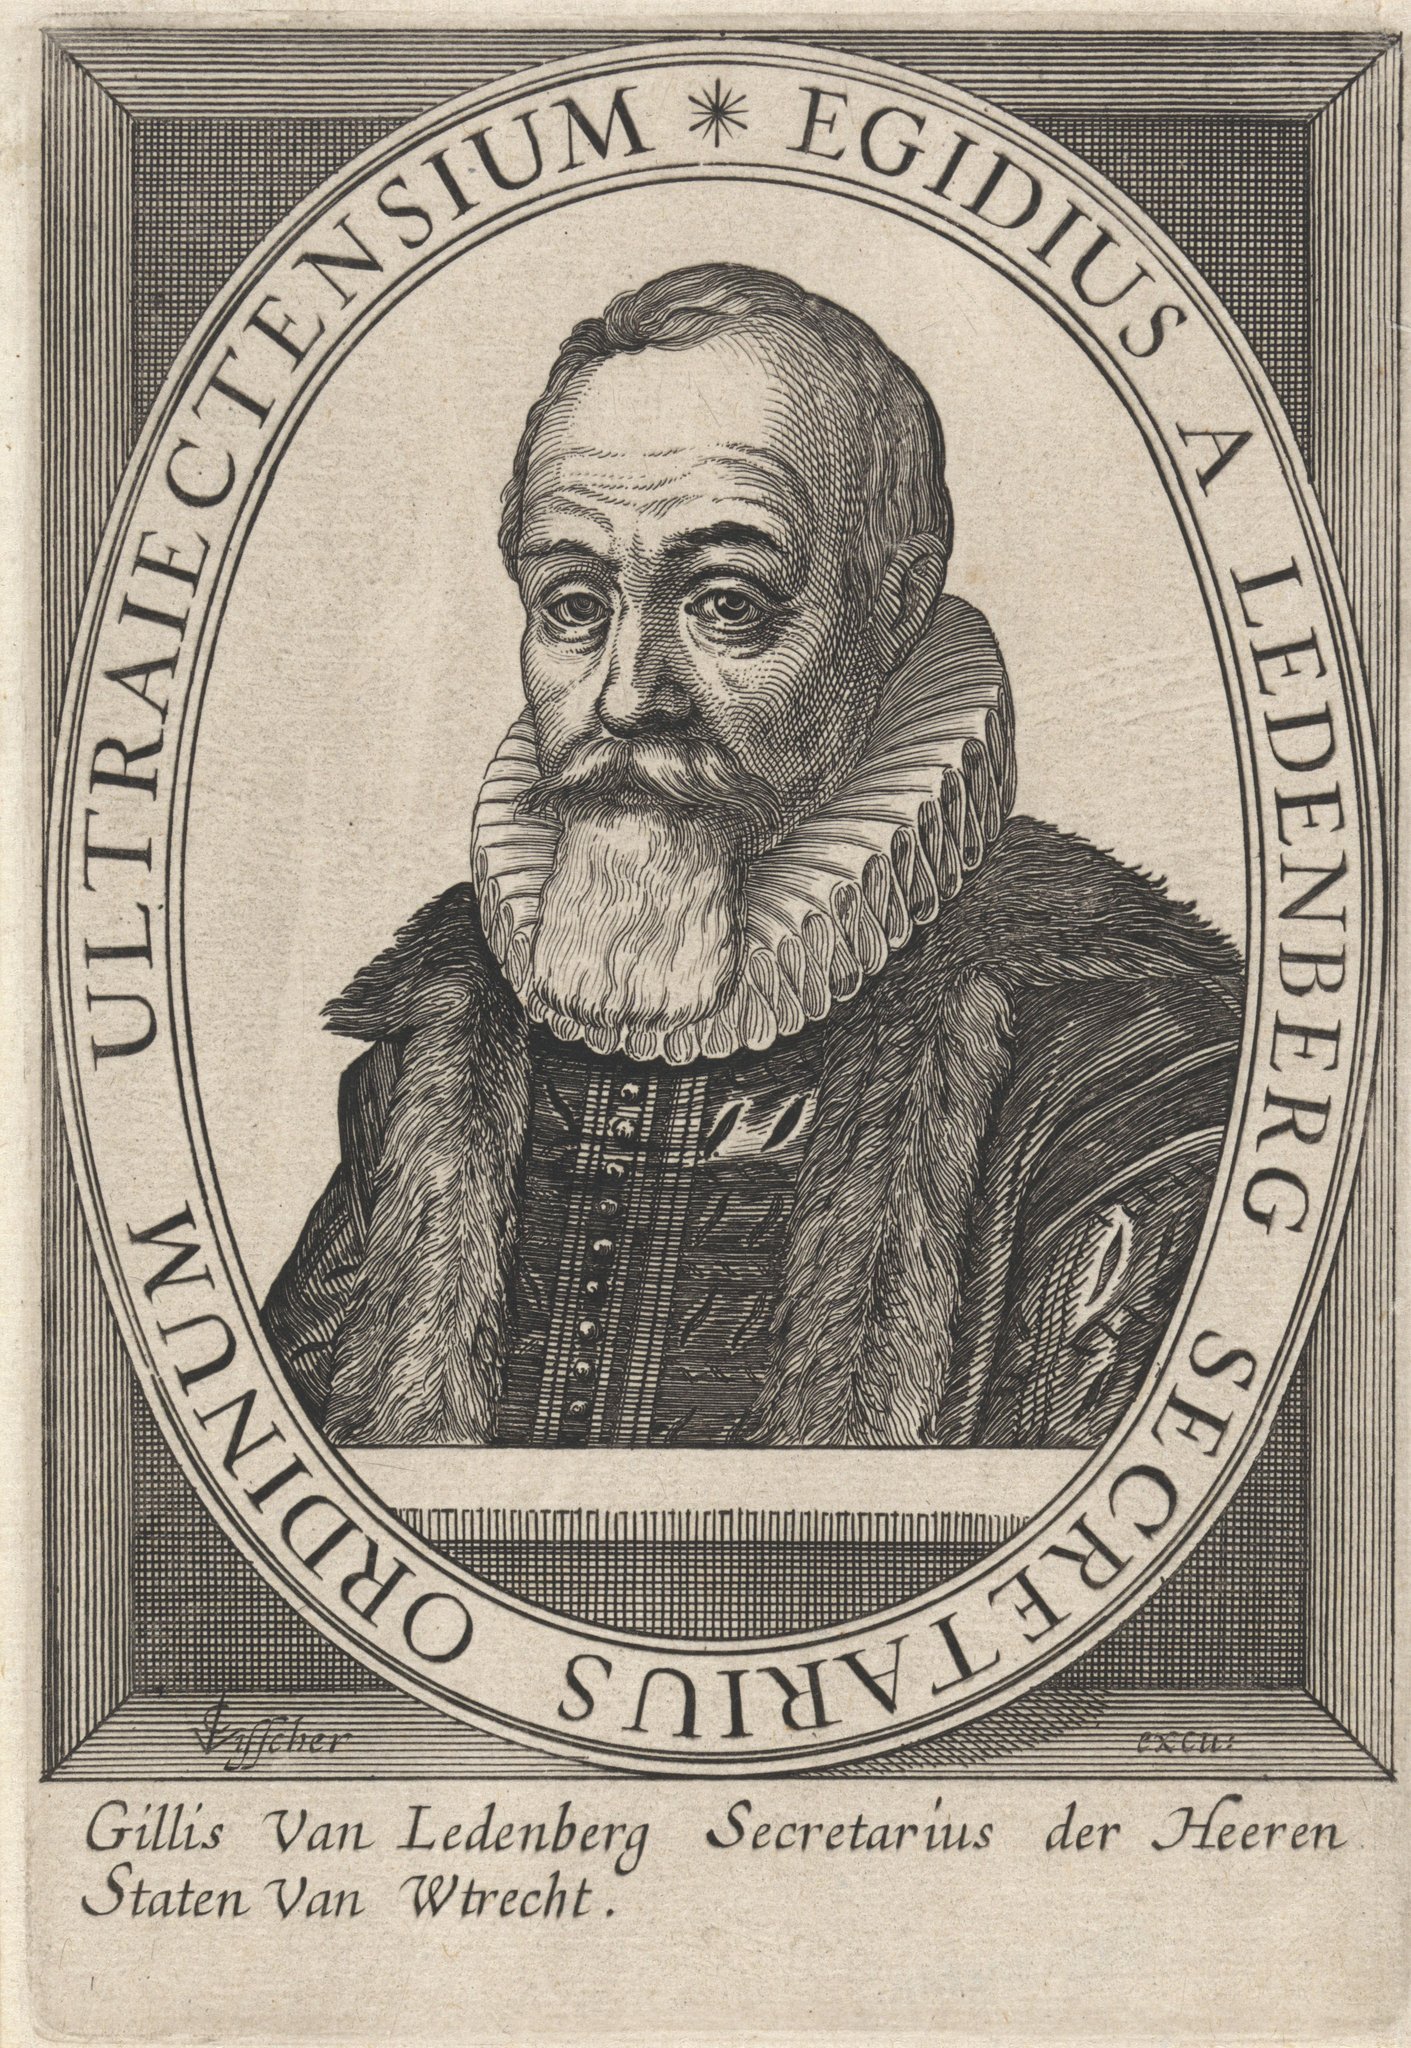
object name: print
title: Portret van Gilles van Ledenberg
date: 1619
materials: paper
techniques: engraving, etching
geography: amsterdam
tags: utrecht, the hague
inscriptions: collector's mark: Lugt 240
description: Een van de voorstellingen die gebruikt is in de grote prent met een overzicht van de gebeurtenissen in 1619 (FM 1385). Niet in Frederik Muller; door het RPK toegevoegd nummer.